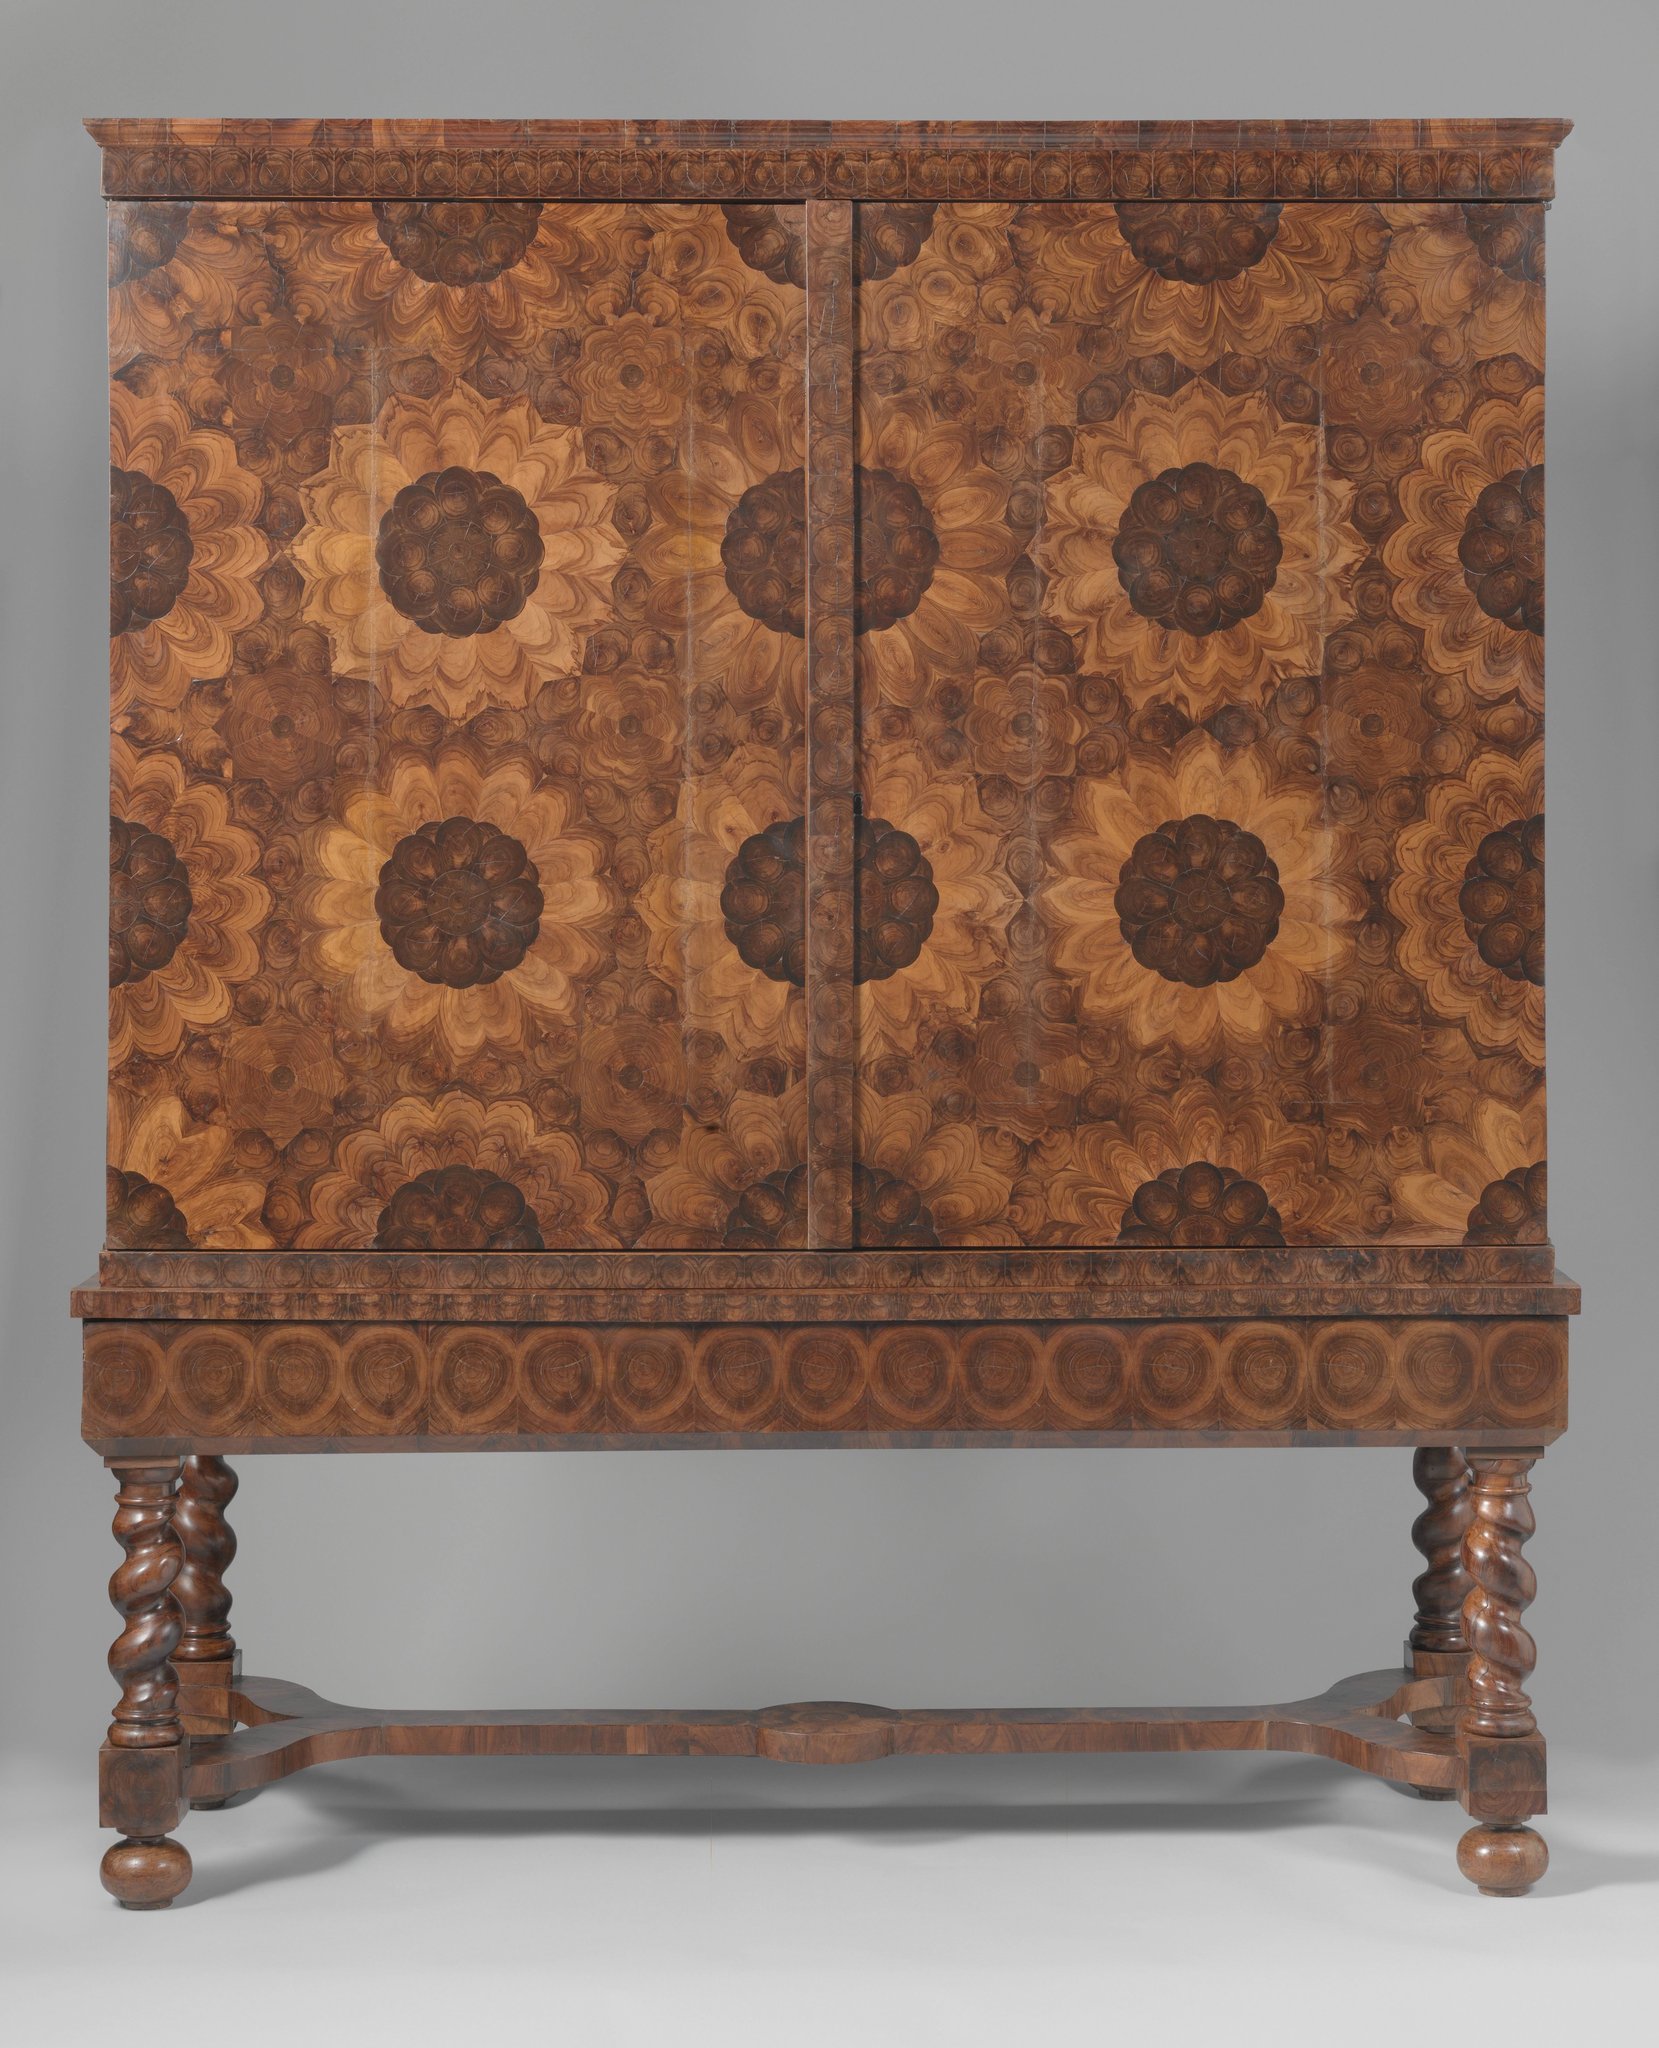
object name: sterkabinet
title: Cabinet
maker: Anonymous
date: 1680-1700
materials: wood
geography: netherlands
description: This type of block-shaped cabinet on a stand became fashionable towards the end of the 17th century. While diverse items could be kept in them, they were mostly used for linen. Due to the absence of carved ornamentation, all attention is drawn to the decoration of the flat front and sides, which consists of thin discs of olive wood assembled into floral-like patterns.